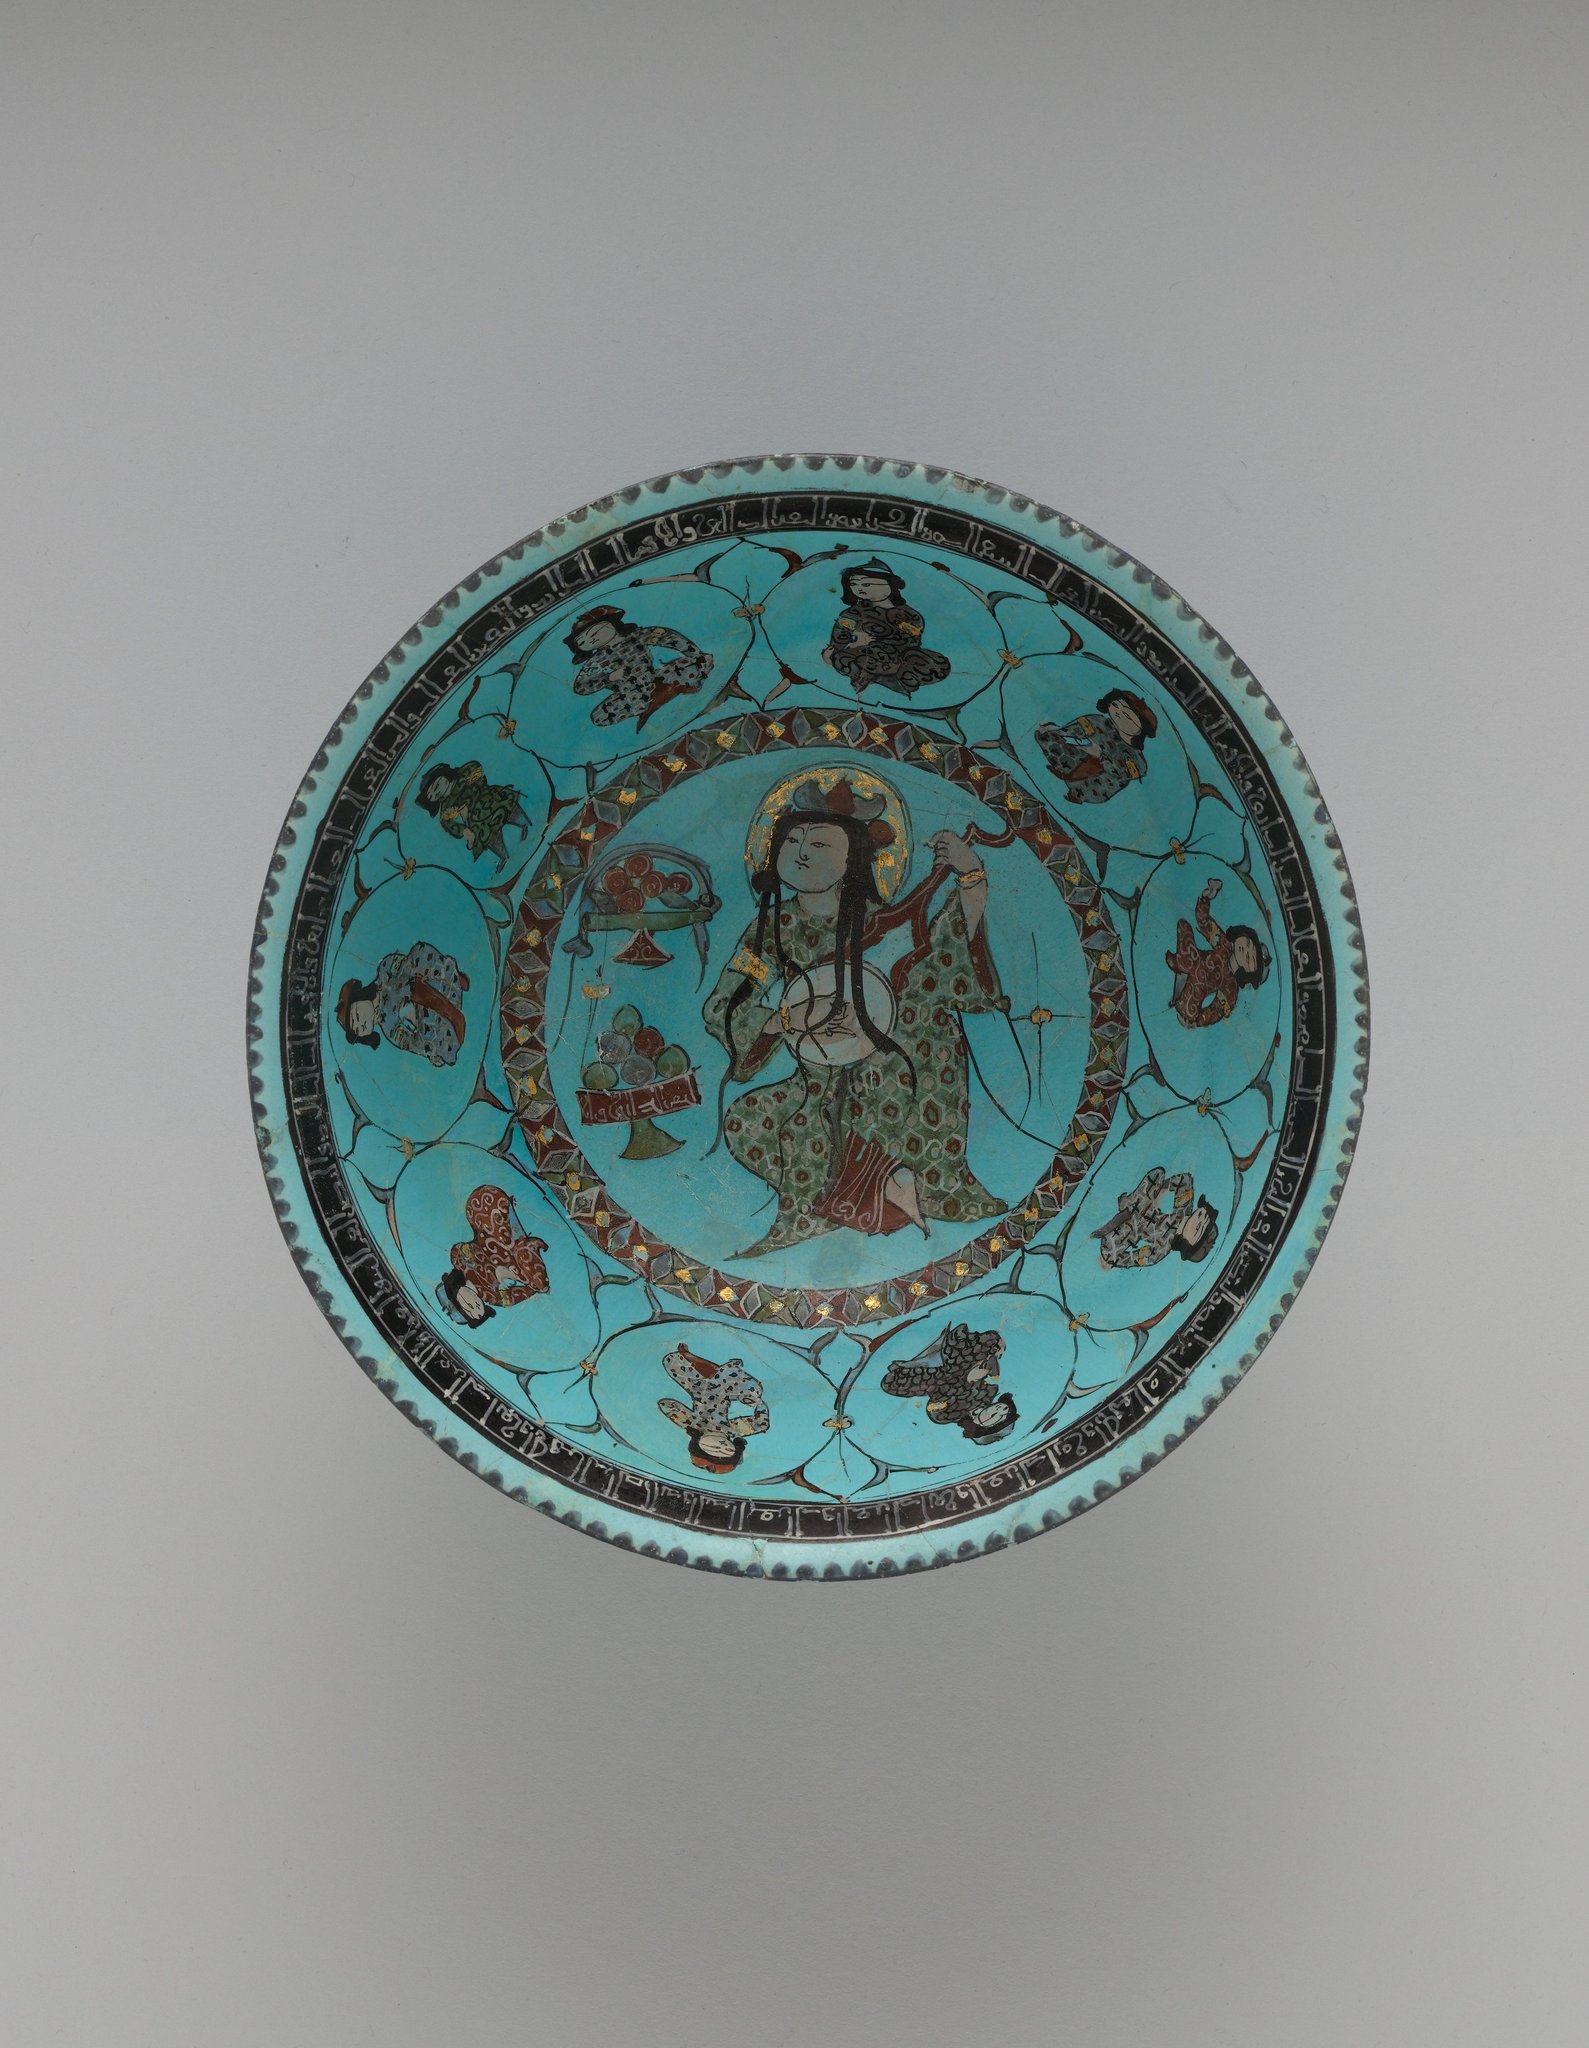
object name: bowl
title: Turquoise Bowl with Lute Player and Audience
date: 1167-1233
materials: glaze, stonepaste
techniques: gilding, glazing, overglaze, painting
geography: iran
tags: arabic,lutes,musicians